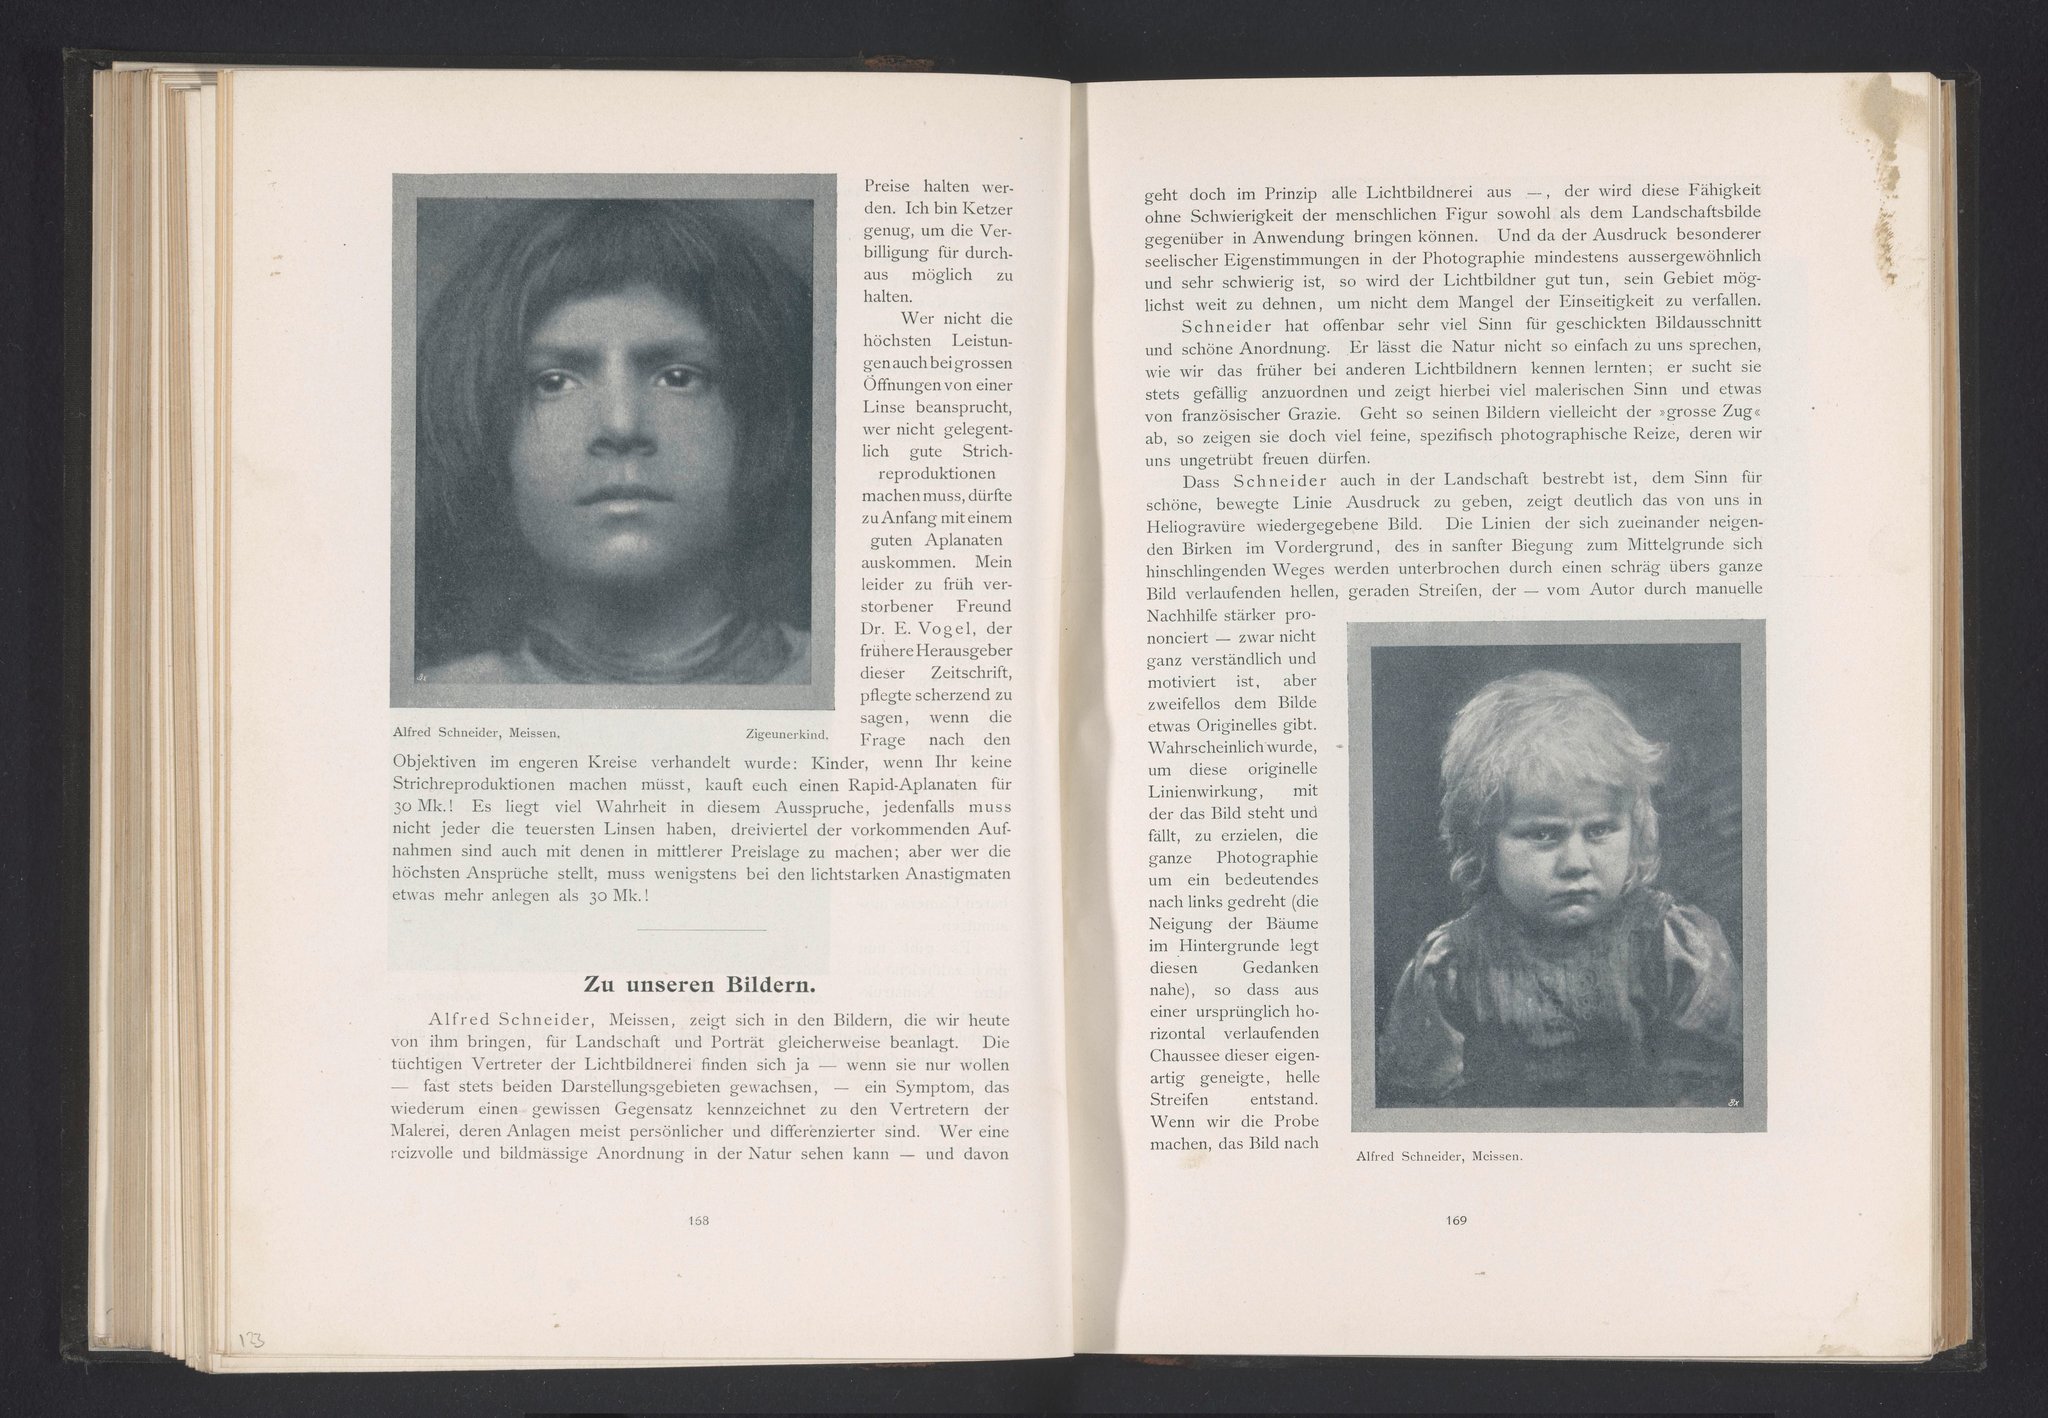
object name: page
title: Portret van een onbekend kind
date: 1898-1903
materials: paper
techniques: autotype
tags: historical persons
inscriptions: monogram: ‘BX’